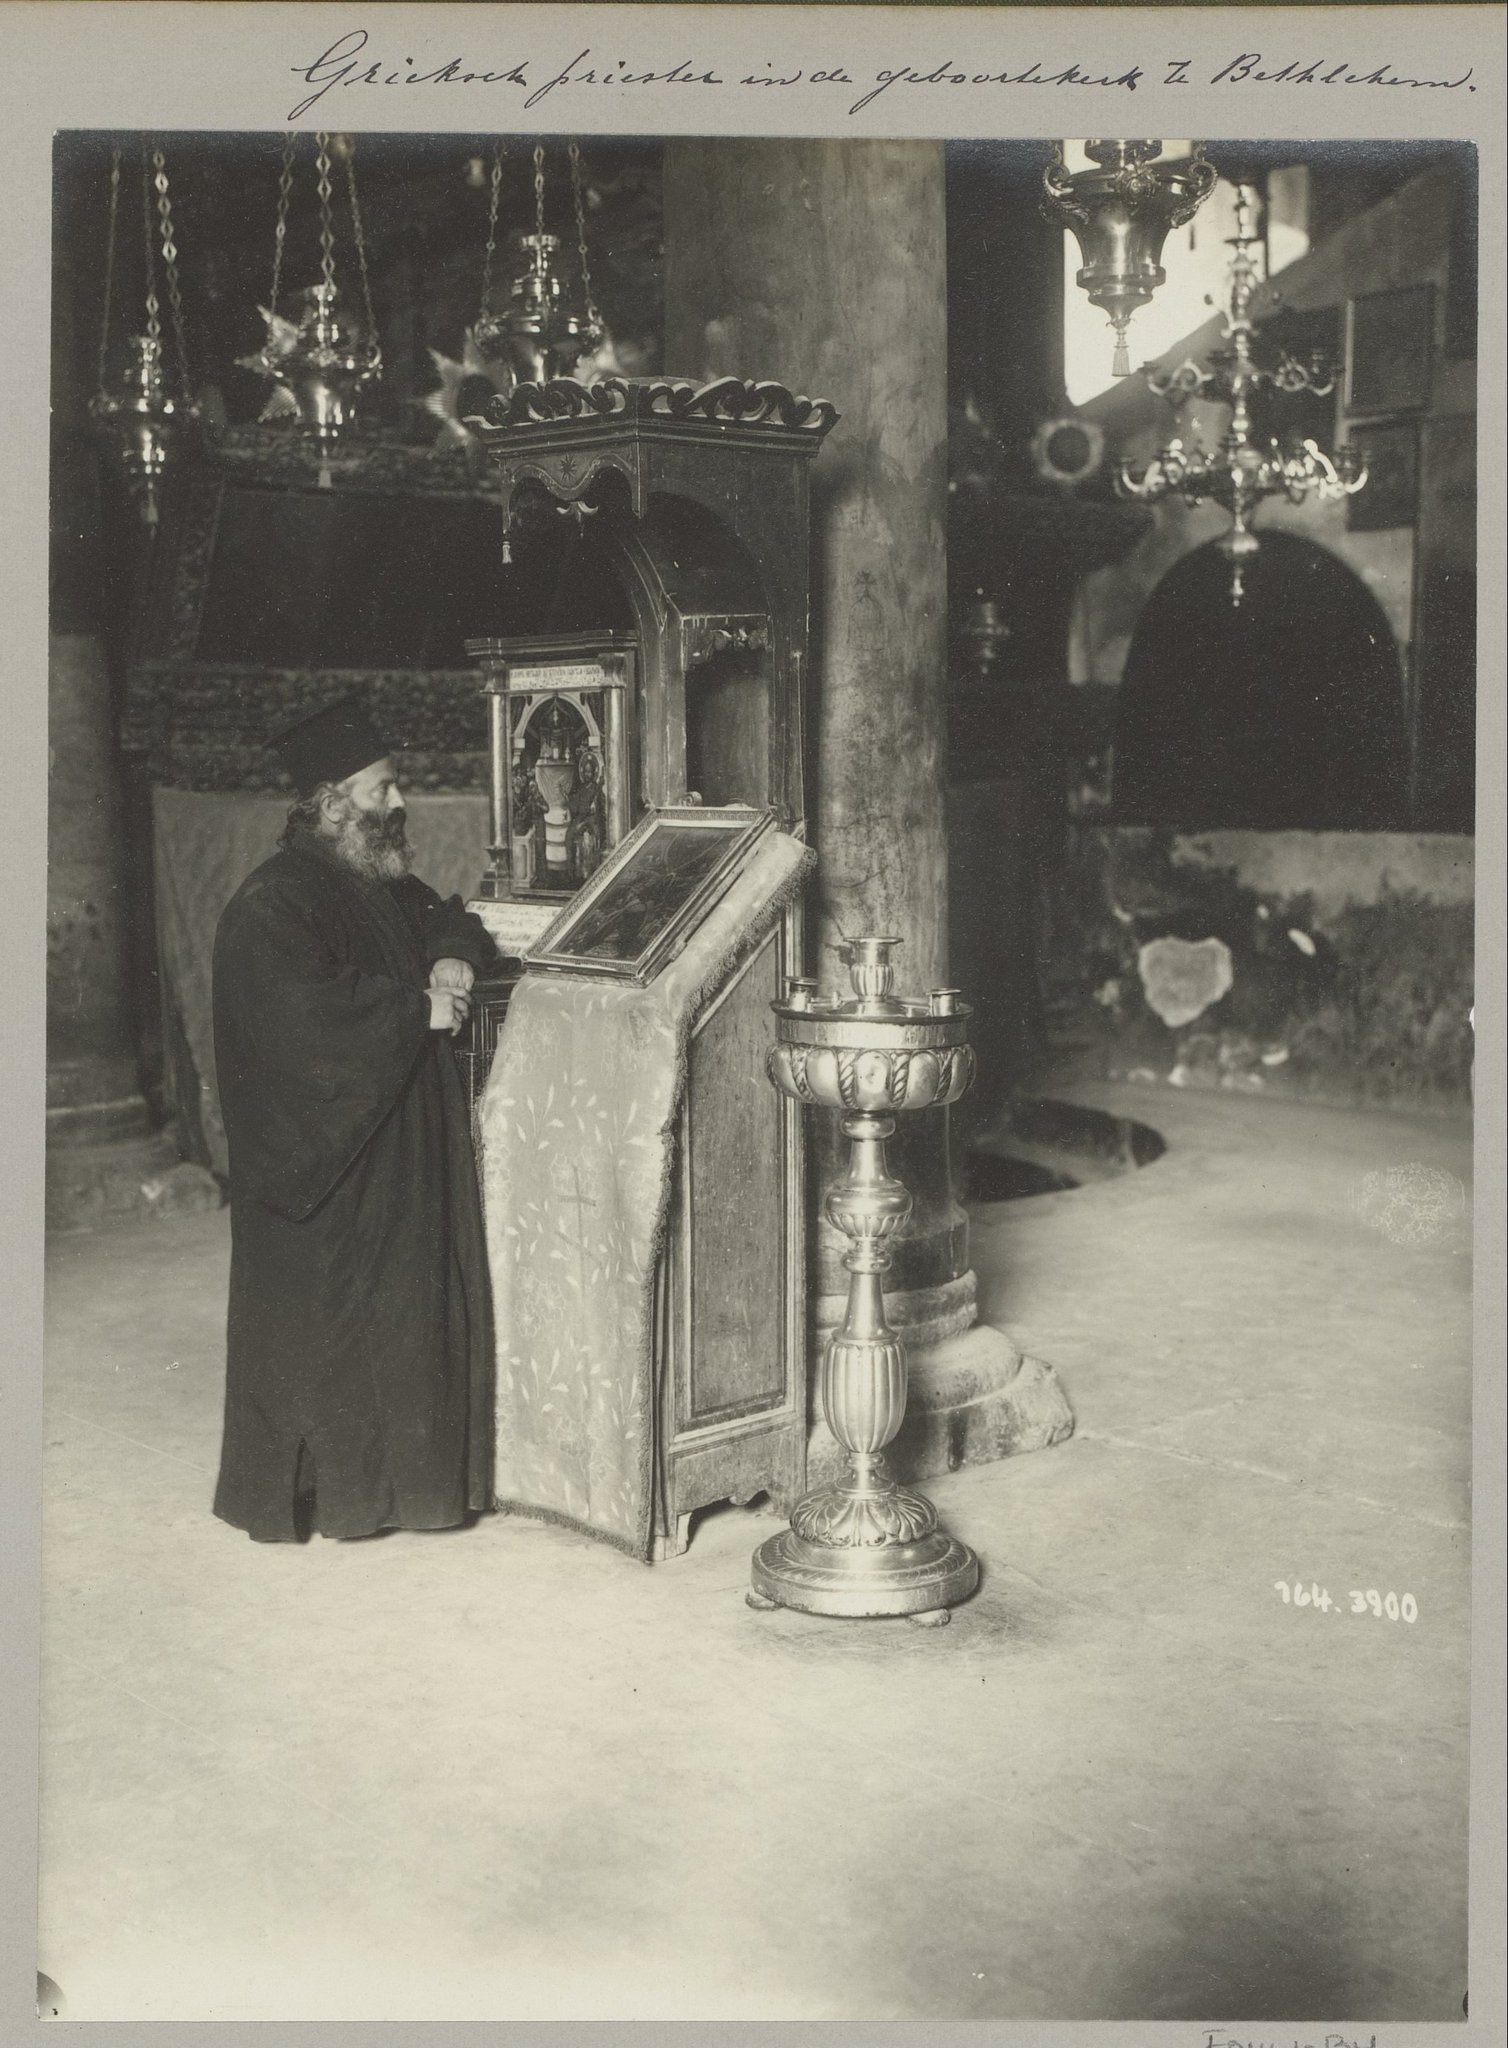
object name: photograph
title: Grieks-orthodoxe priester in de Geboortekerk in Bethlehem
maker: Anonymous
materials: photographic support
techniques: gelatin silver print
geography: bethlehem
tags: interior of church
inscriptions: number: ‘164. 3900’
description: Onderdeel van Fotoalbum van een reis door Zuid-Europa en het Midden-Oosten.